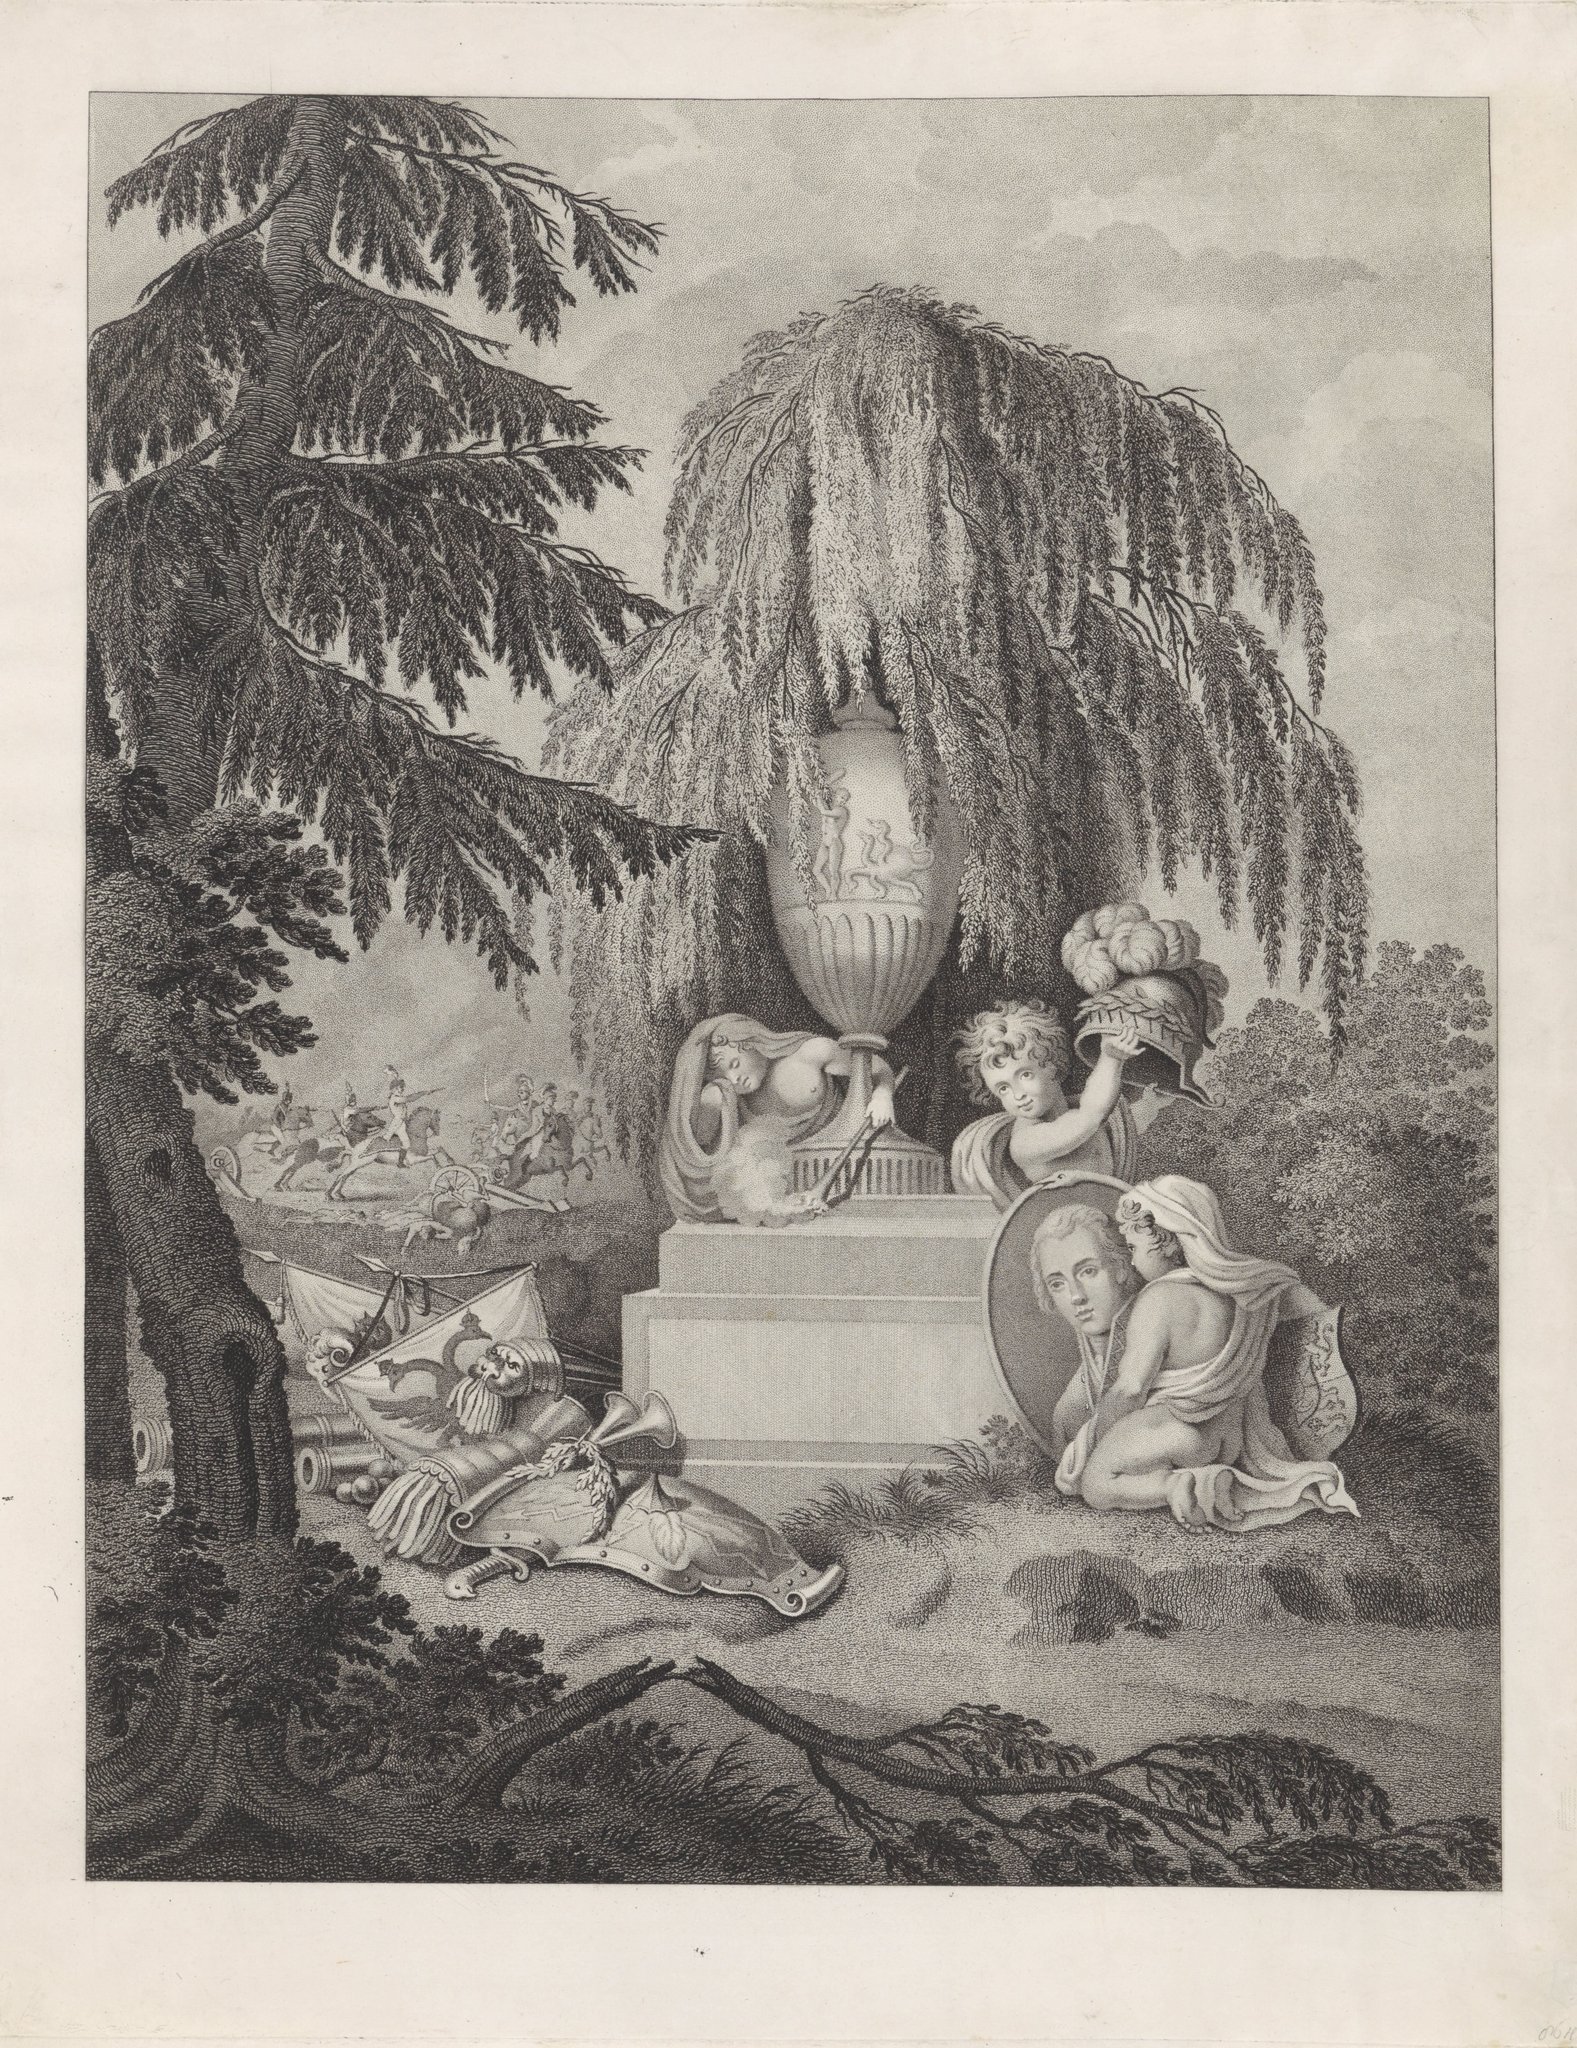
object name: print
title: Allegorisch gedenkteken voor Willem George Frederik, prins van Oranje-Nassau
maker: jacobus wijsman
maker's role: print maker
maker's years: 1768-1827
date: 1799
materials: paper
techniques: etching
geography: amsterdam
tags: the hague, willem george frederik (prins van oranje-nassau), torch - bb - torch held upside down, grave-building, monumental tomb, cupids: 'amores', 'amoretti', 'putti'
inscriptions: collector's mark: Lugt 2228, collector's mark: Lugt 963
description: Allegorisch gedenkteken voor Willem George Frederik, prins van Oranje-Nassau, overleden te Padua, 6 januari 1799. Bij een door een treurwilg overschaduwd monument staat een treurende putto met een gedoofde toorts. Een andere putto toont een helm en de derde zit bij het portret. Op de grond voor het monument een wapenrusting en vaandels, op de achtergrond een ruitergevecht.